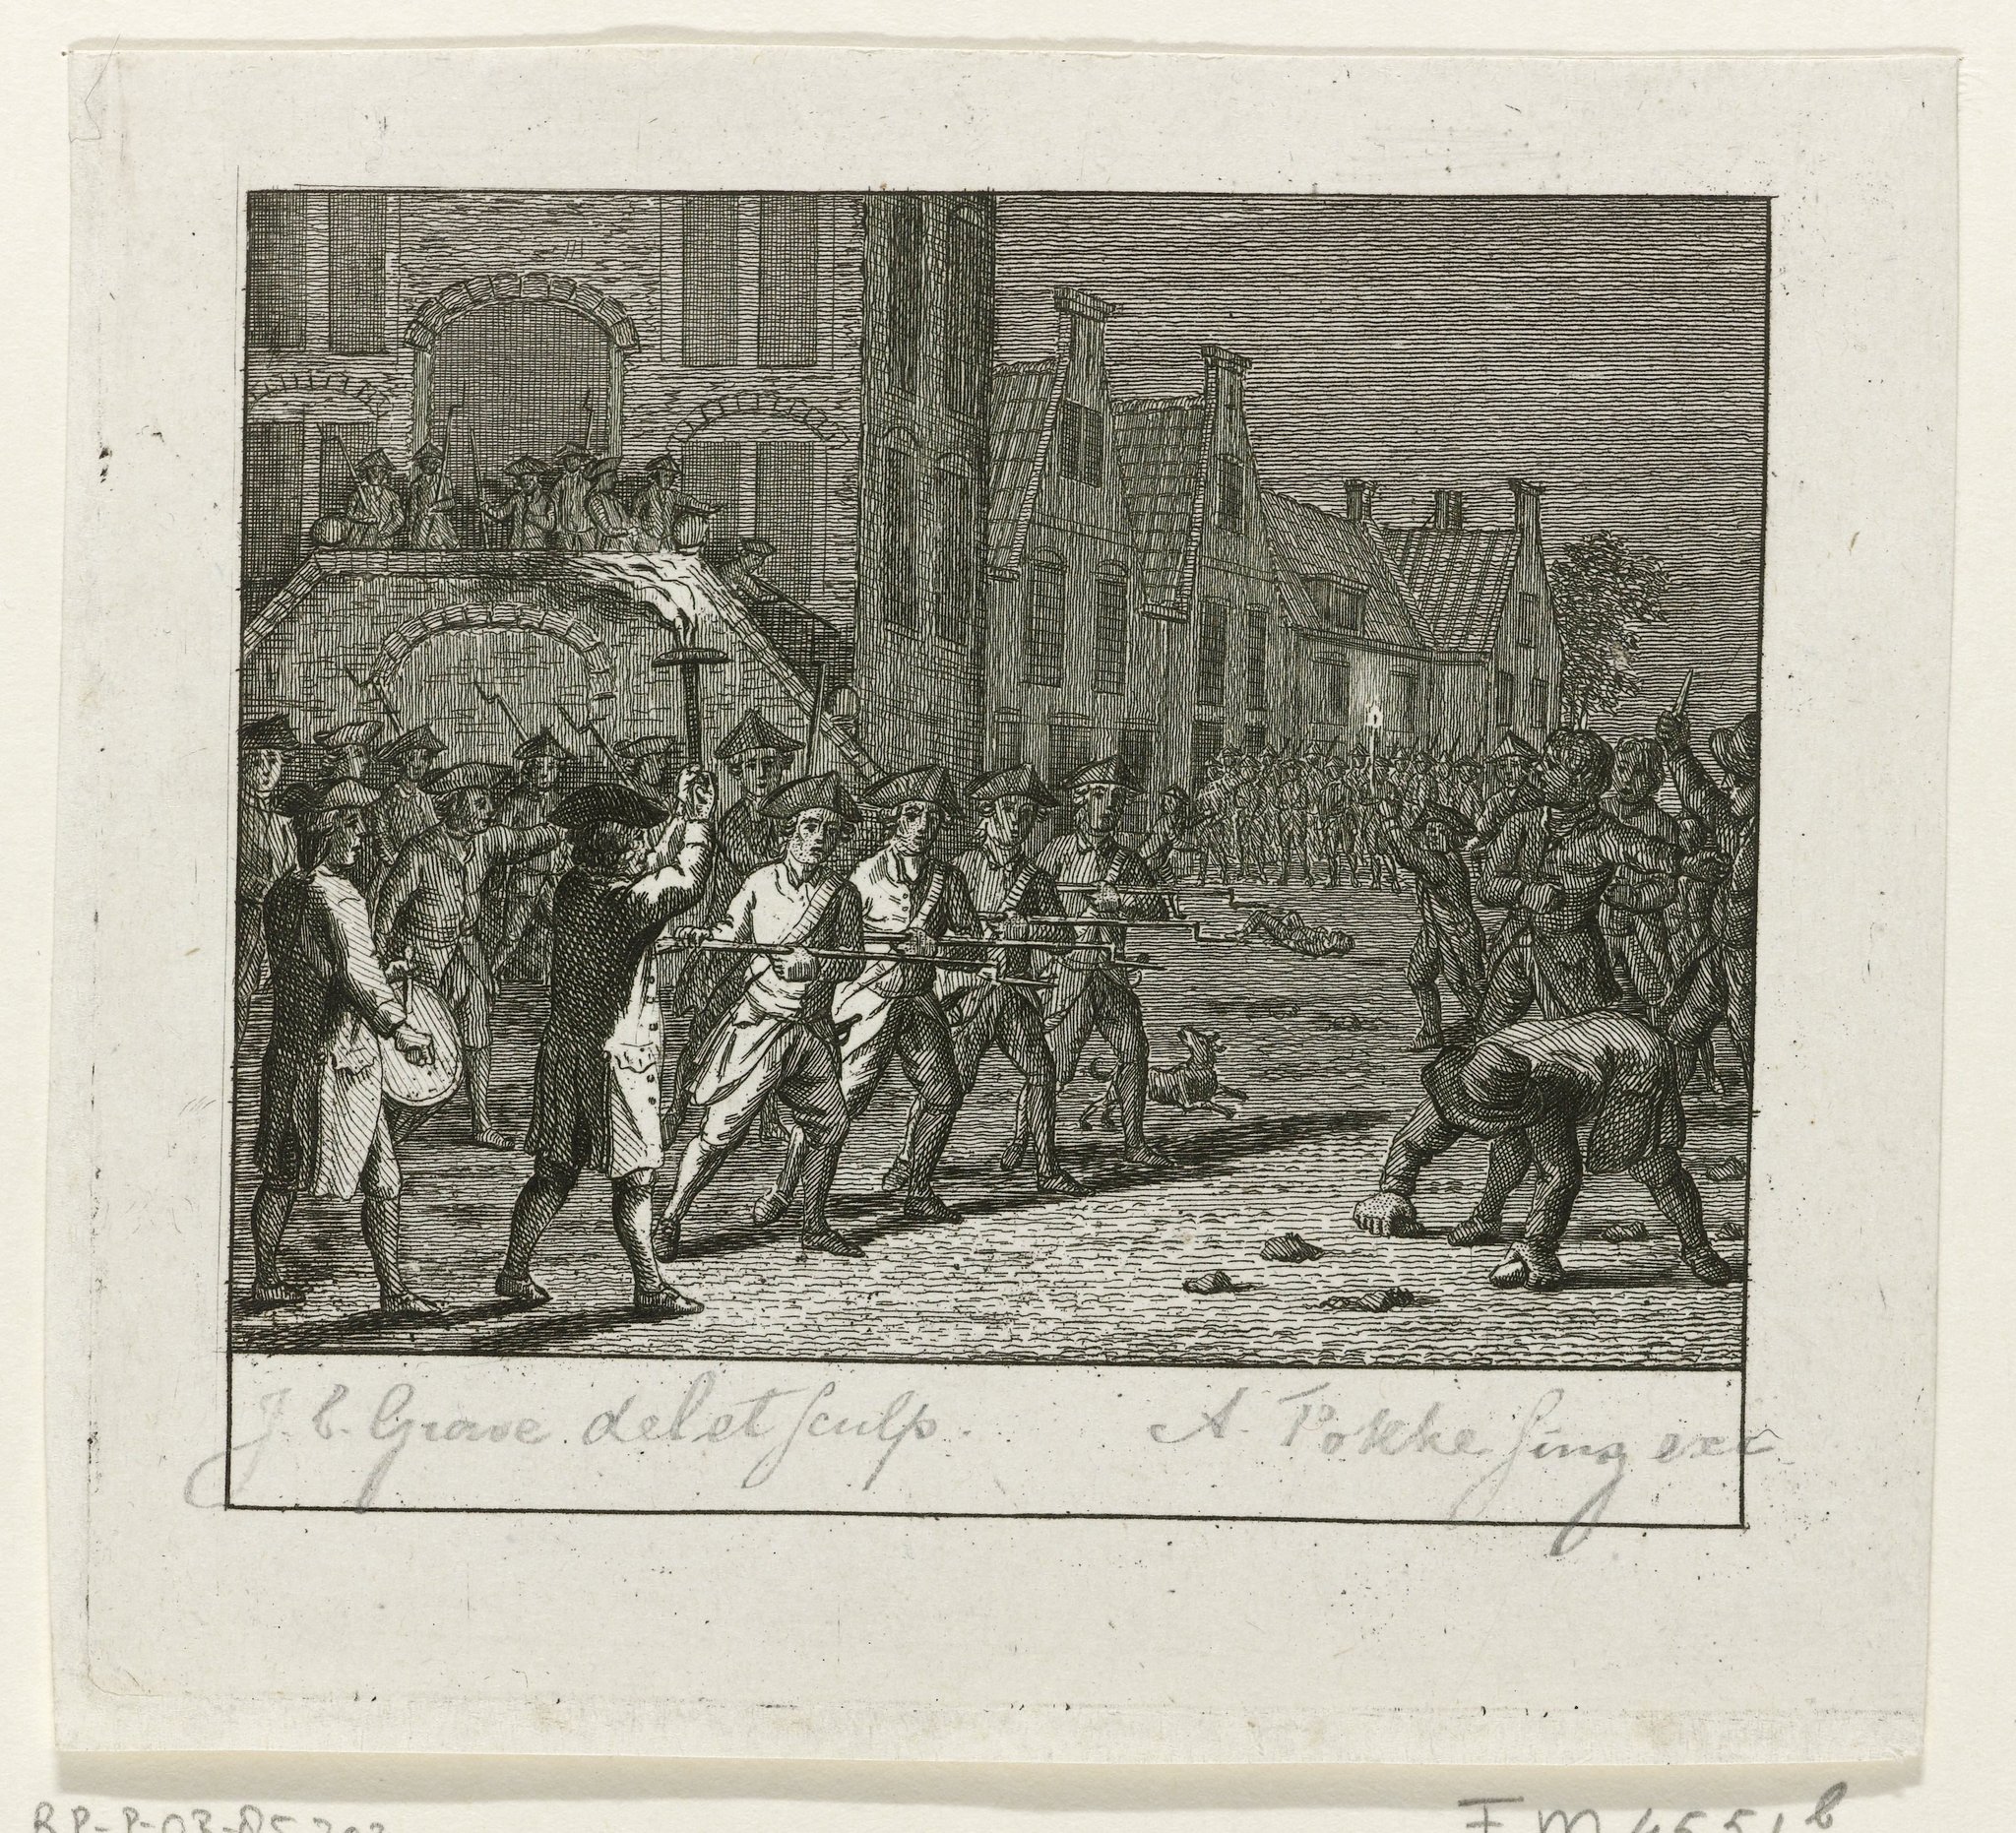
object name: print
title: Geweld tussen burgercompagnie en orangisten te Rotterdam, 1784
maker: jan evert grave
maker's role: draughtsman, print maker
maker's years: 1759-1805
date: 1784-1792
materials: paper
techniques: etching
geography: northern netherlands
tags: street-fights, riots, rotterdam, patriots (1780-1795)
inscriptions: collector's mark: Lugt 2228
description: Gebruikt als illustratie in: Arend Fokke Simonsz. De vaderlandsche historie in themata. Amsterdam: Arend Fokke Simonsz., edities tussen 1783-ca. 1792.